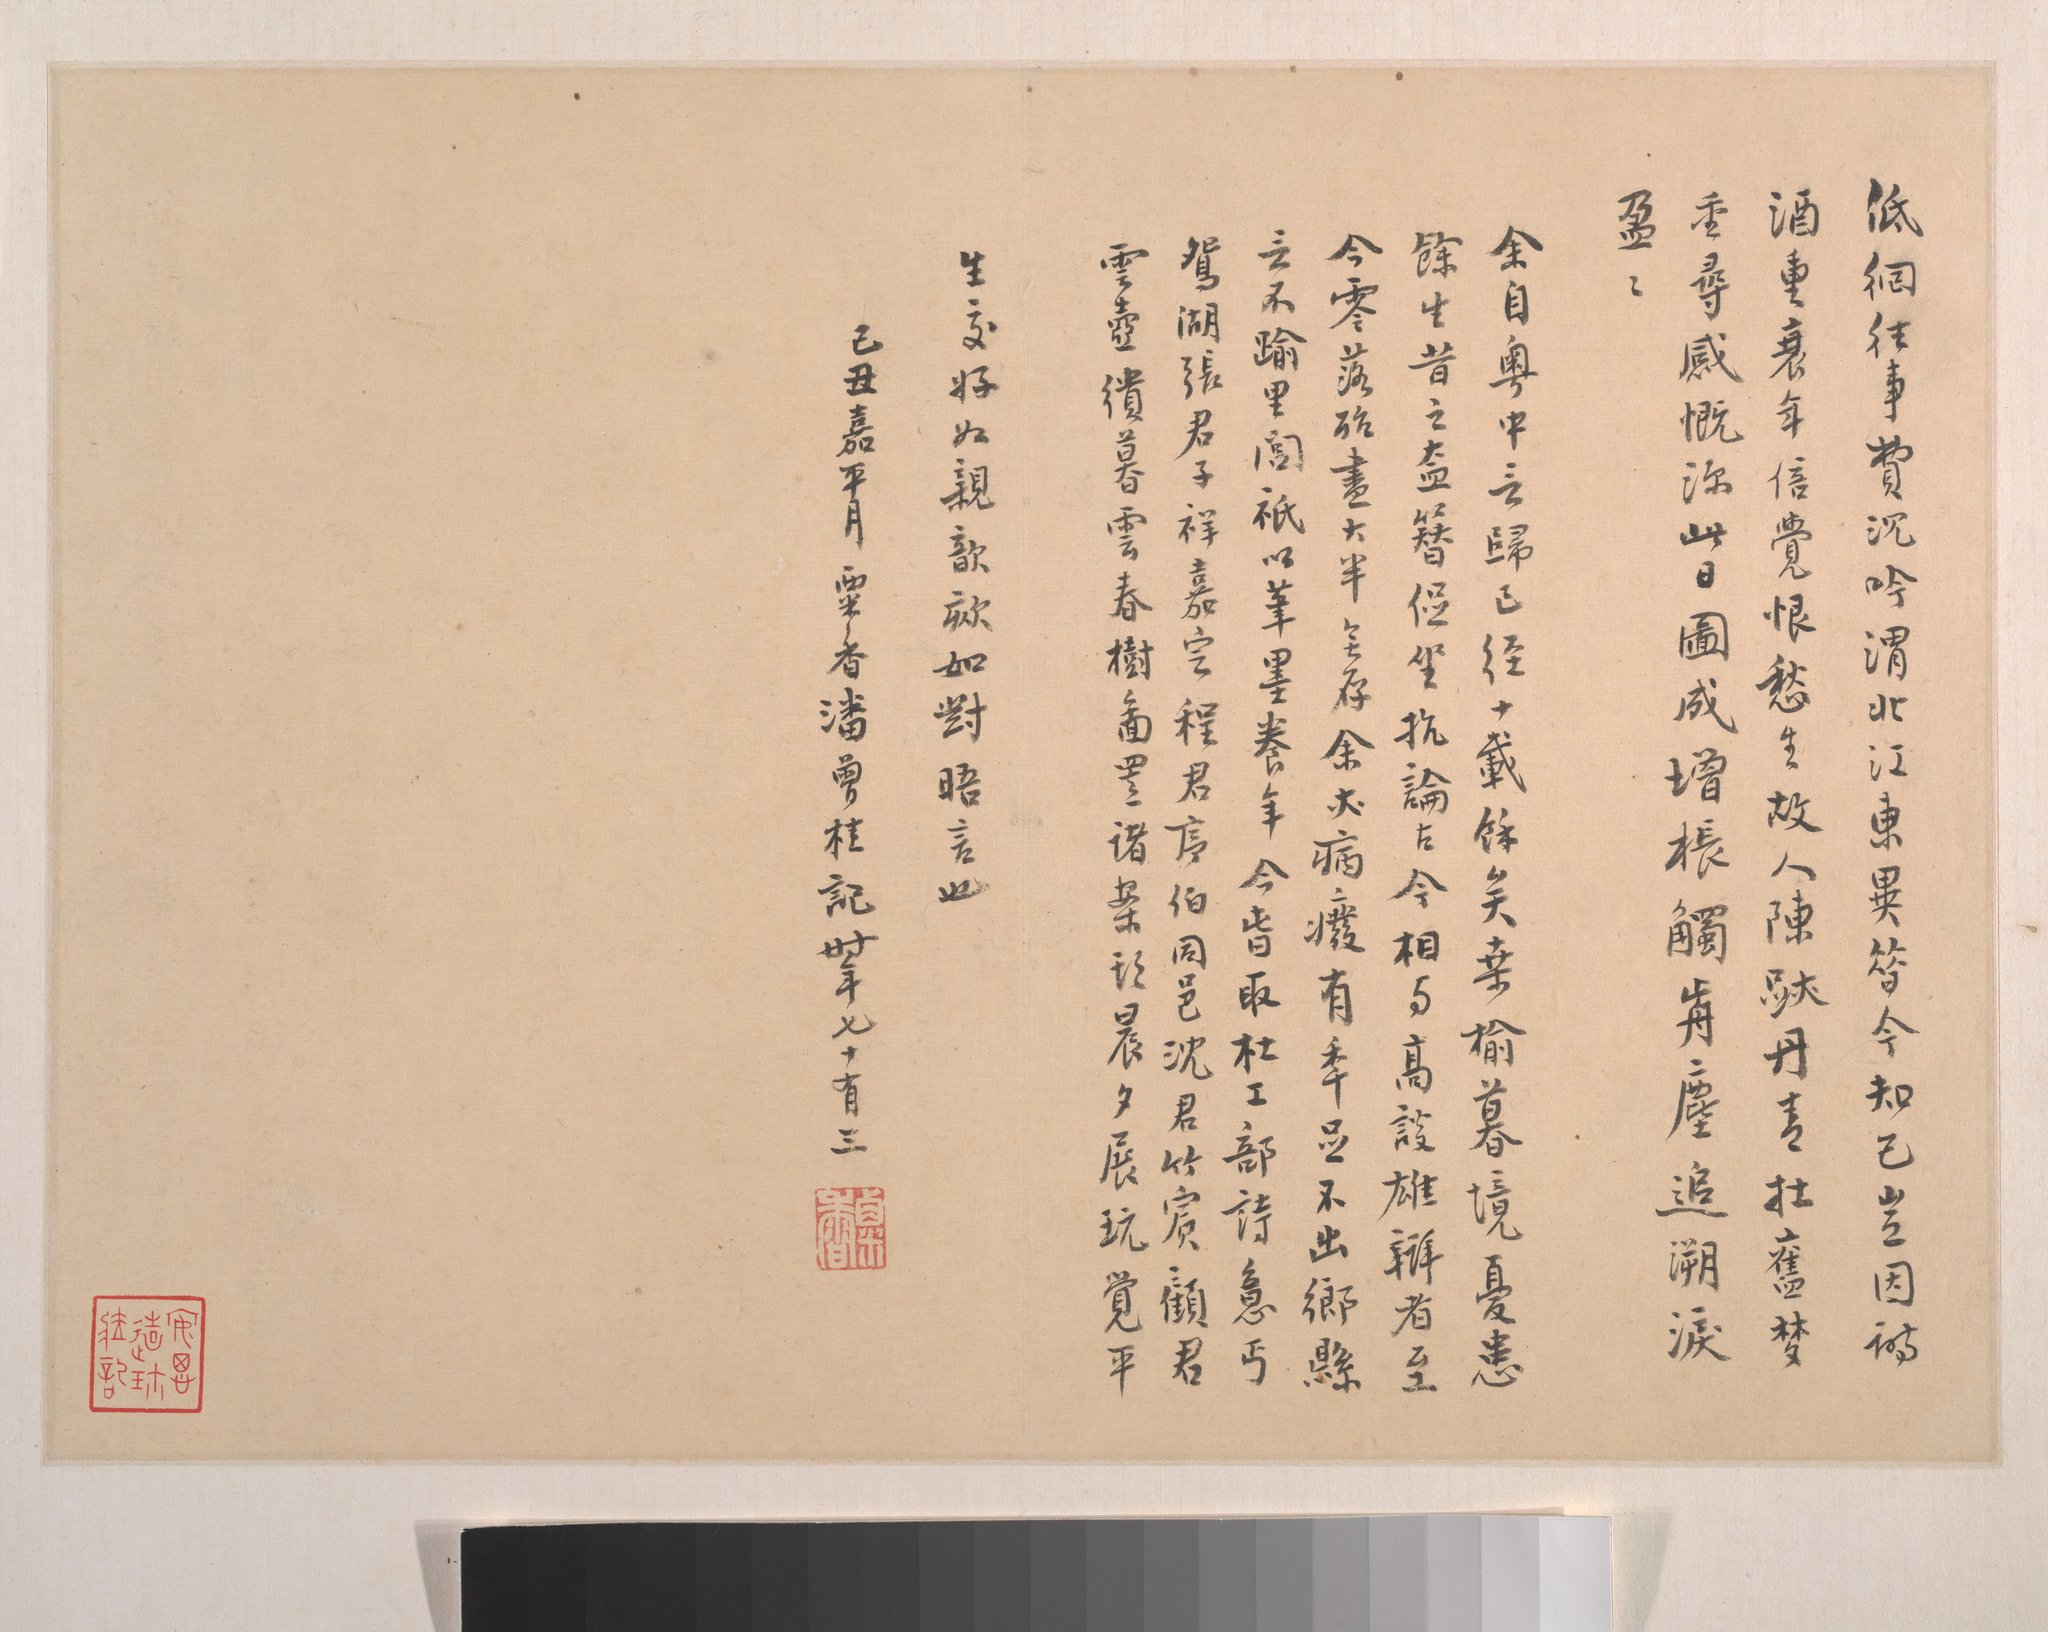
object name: album leaf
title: Poem and Colophon to the Album of Paintings, "Clouds and Spring Trees at Dusk"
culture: chinese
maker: pan zenggui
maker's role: artist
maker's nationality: chinese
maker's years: 1800-1899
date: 1867-1900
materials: ink, paper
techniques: calligraphy